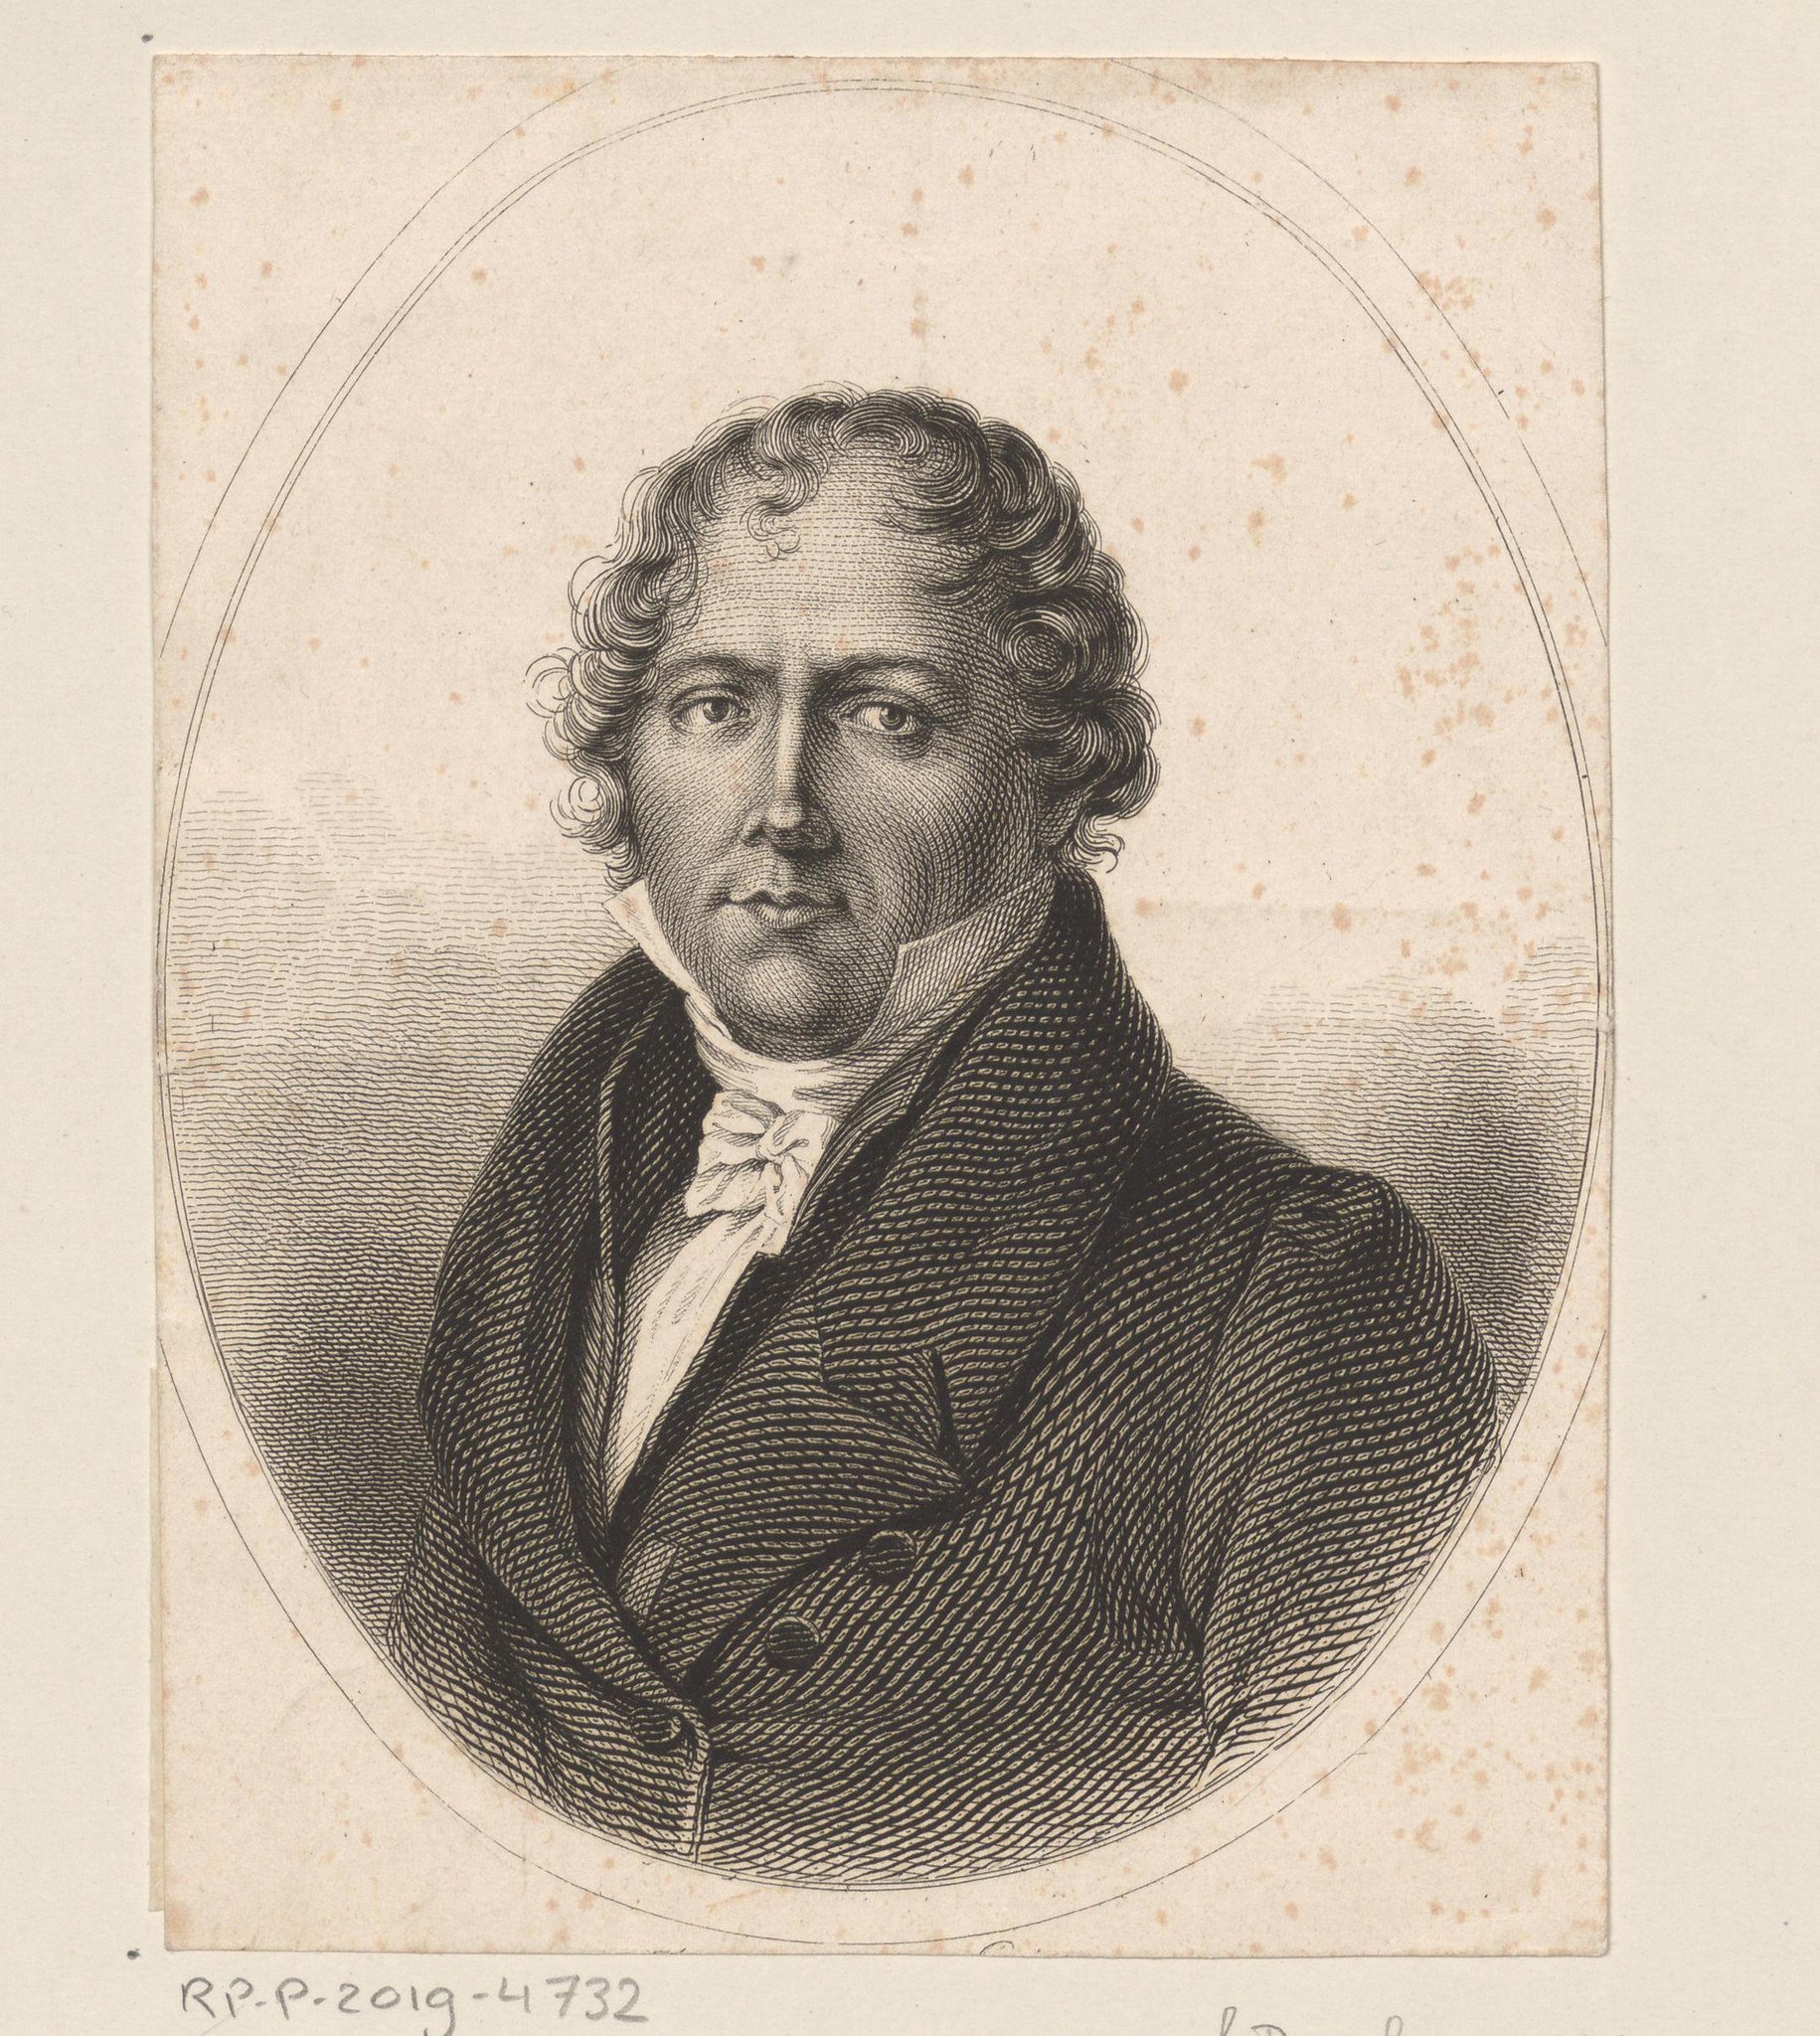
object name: print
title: Portret van Jean-Baptiste Biot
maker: Anonymous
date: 1800-1849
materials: paper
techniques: engraving, etching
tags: paris, physicist, historical persons